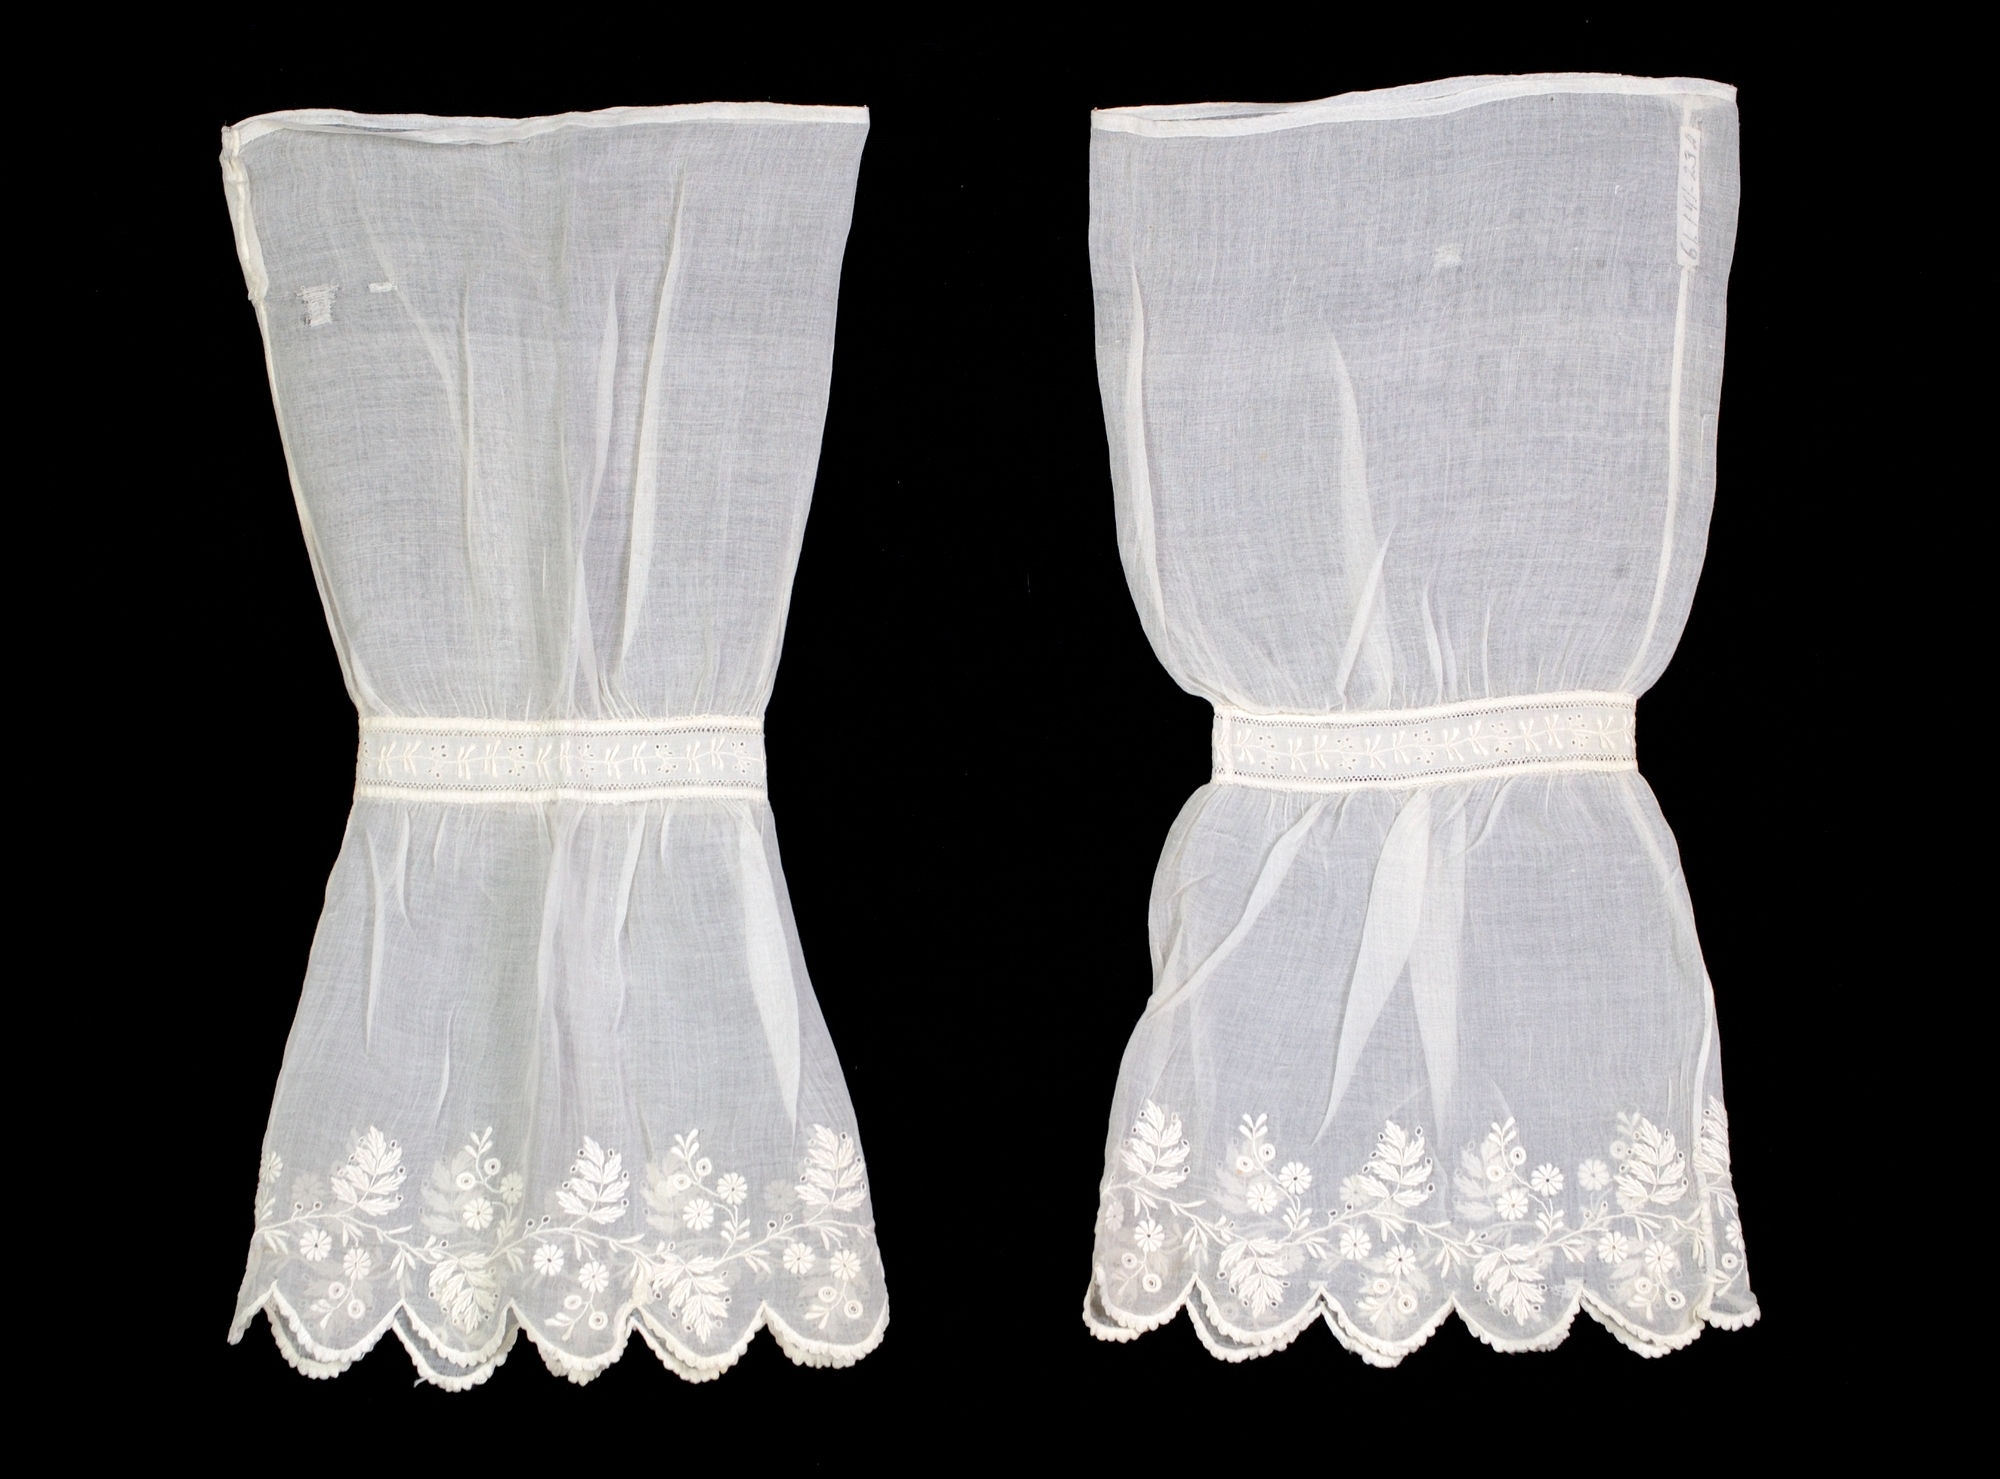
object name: undersleeves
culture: american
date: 1855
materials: cotton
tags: flowers